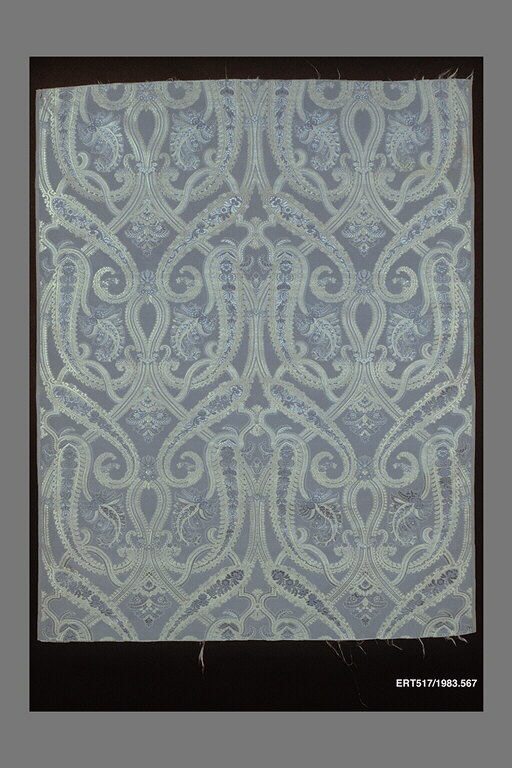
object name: length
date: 1850-1859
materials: silk